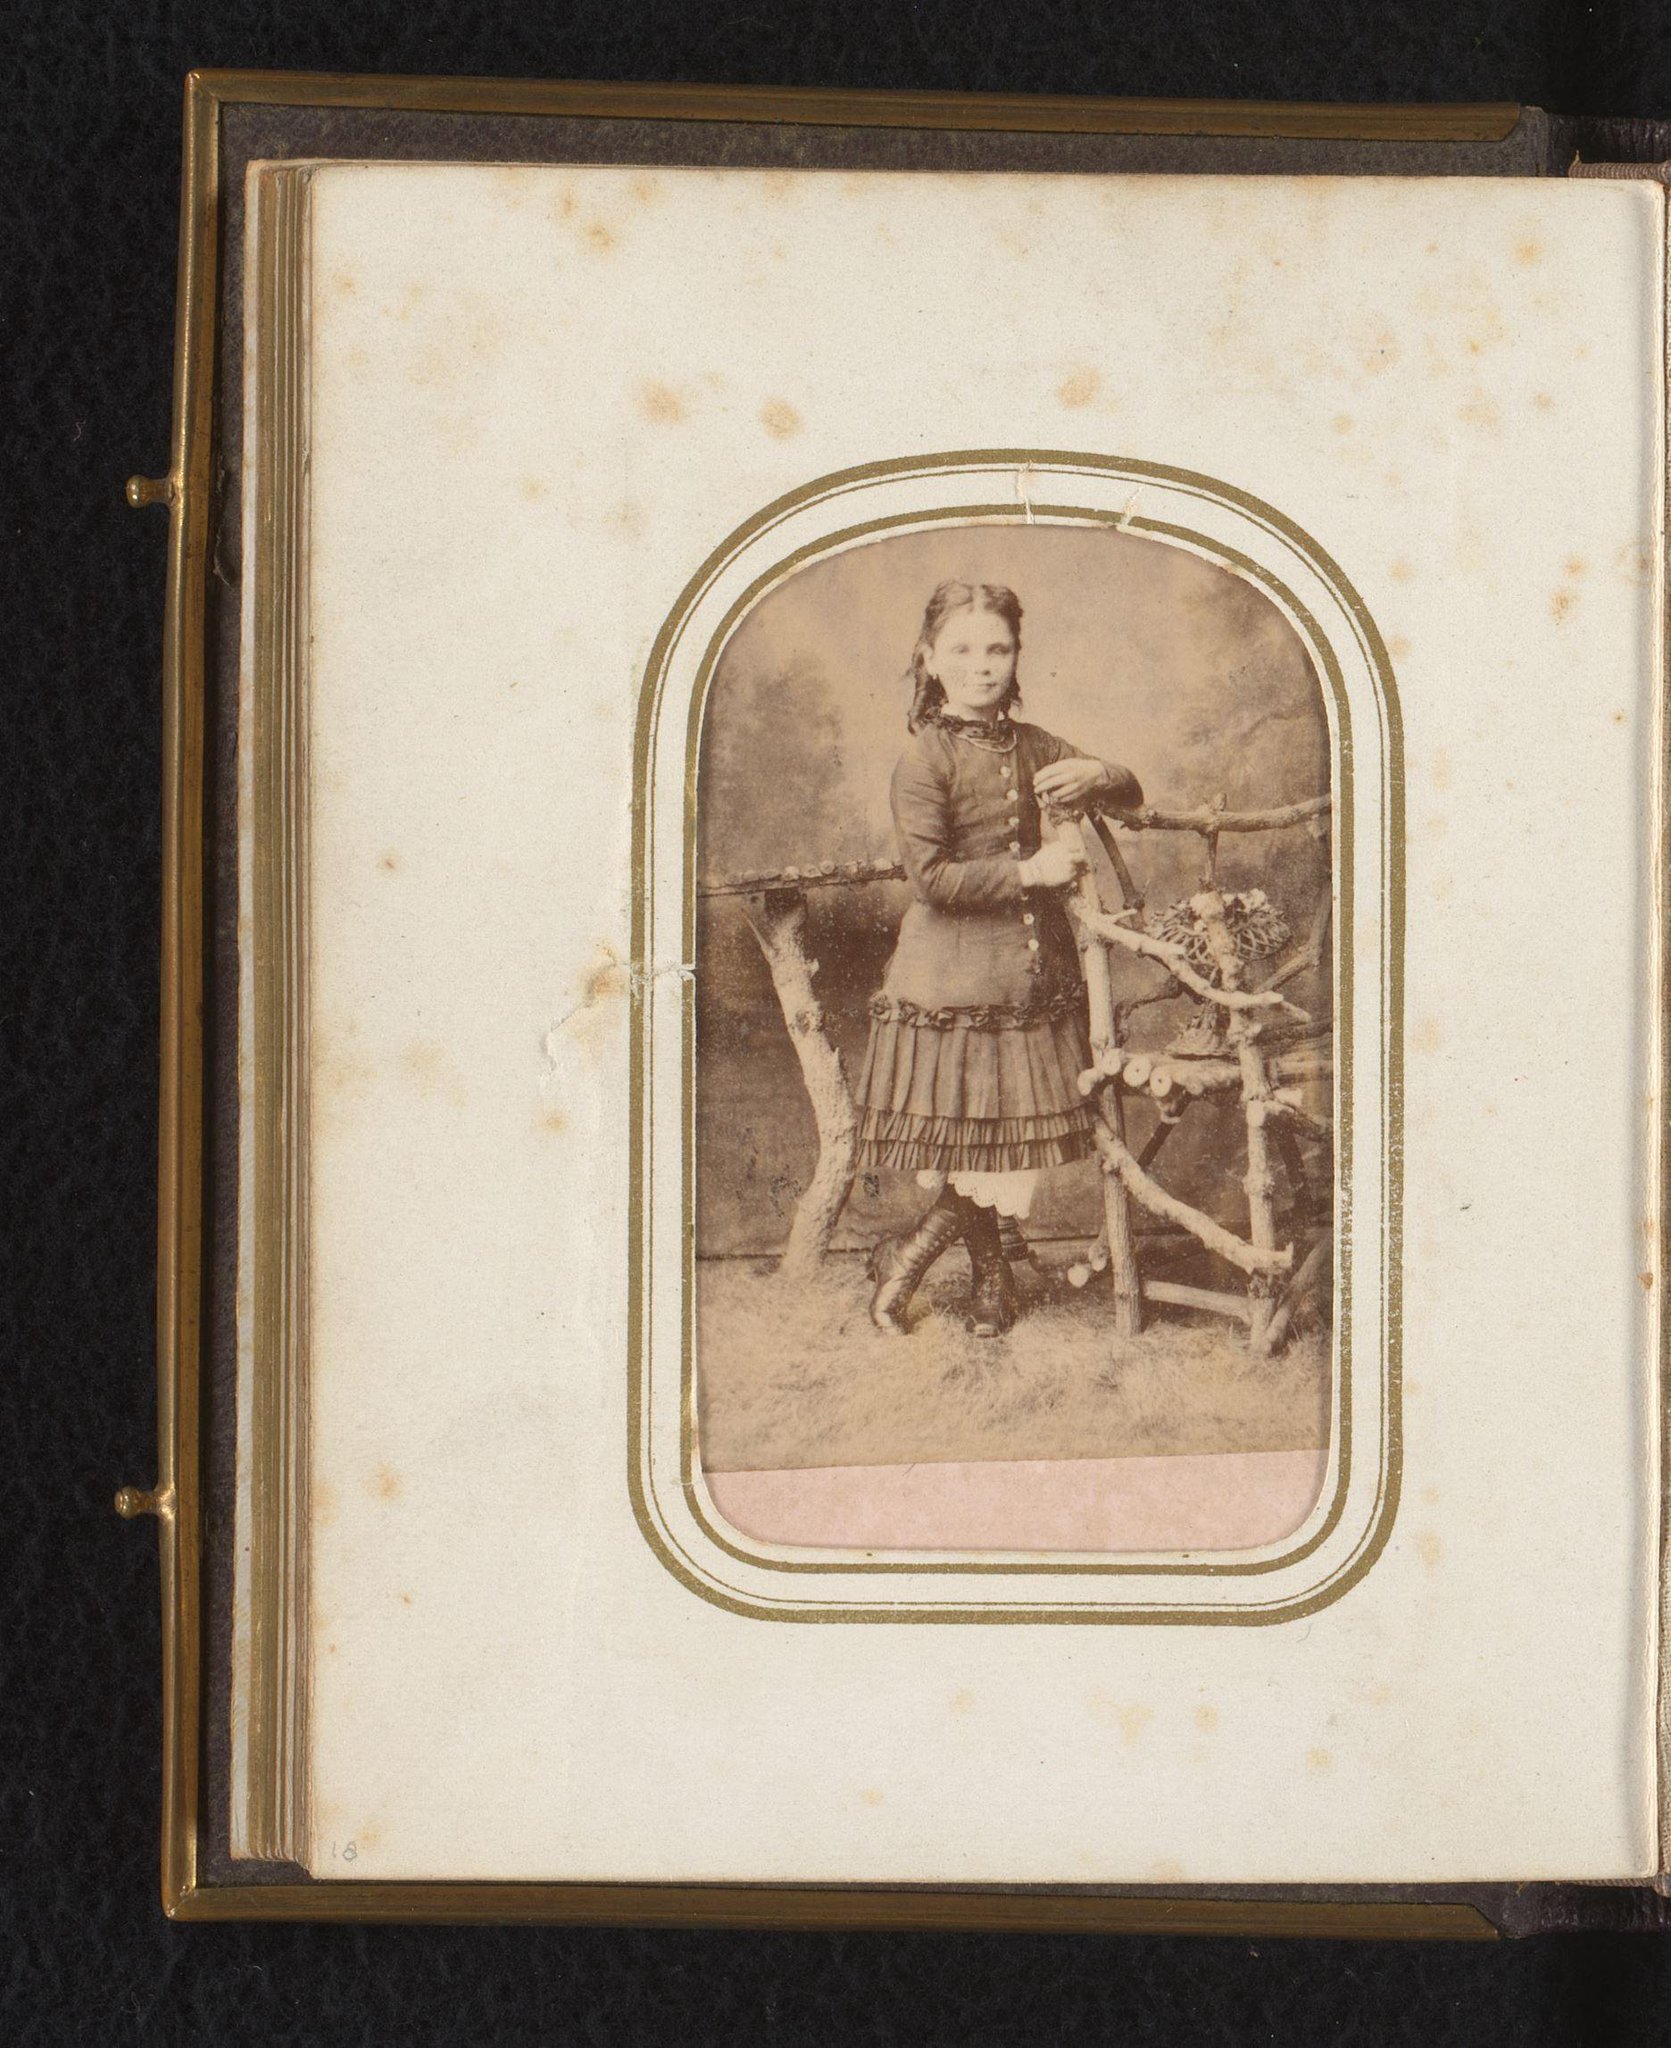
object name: carte de visite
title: Portret van een meisje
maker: albert dekema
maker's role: publisher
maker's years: 1824-1909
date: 1865-1896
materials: cardboard, photographic support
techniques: albumen print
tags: historical persons, girl (child between toddler and youth)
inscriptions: inscription: ‘A. Dekema/ St. Jansstraat/ Enkhuizen/ (...)’